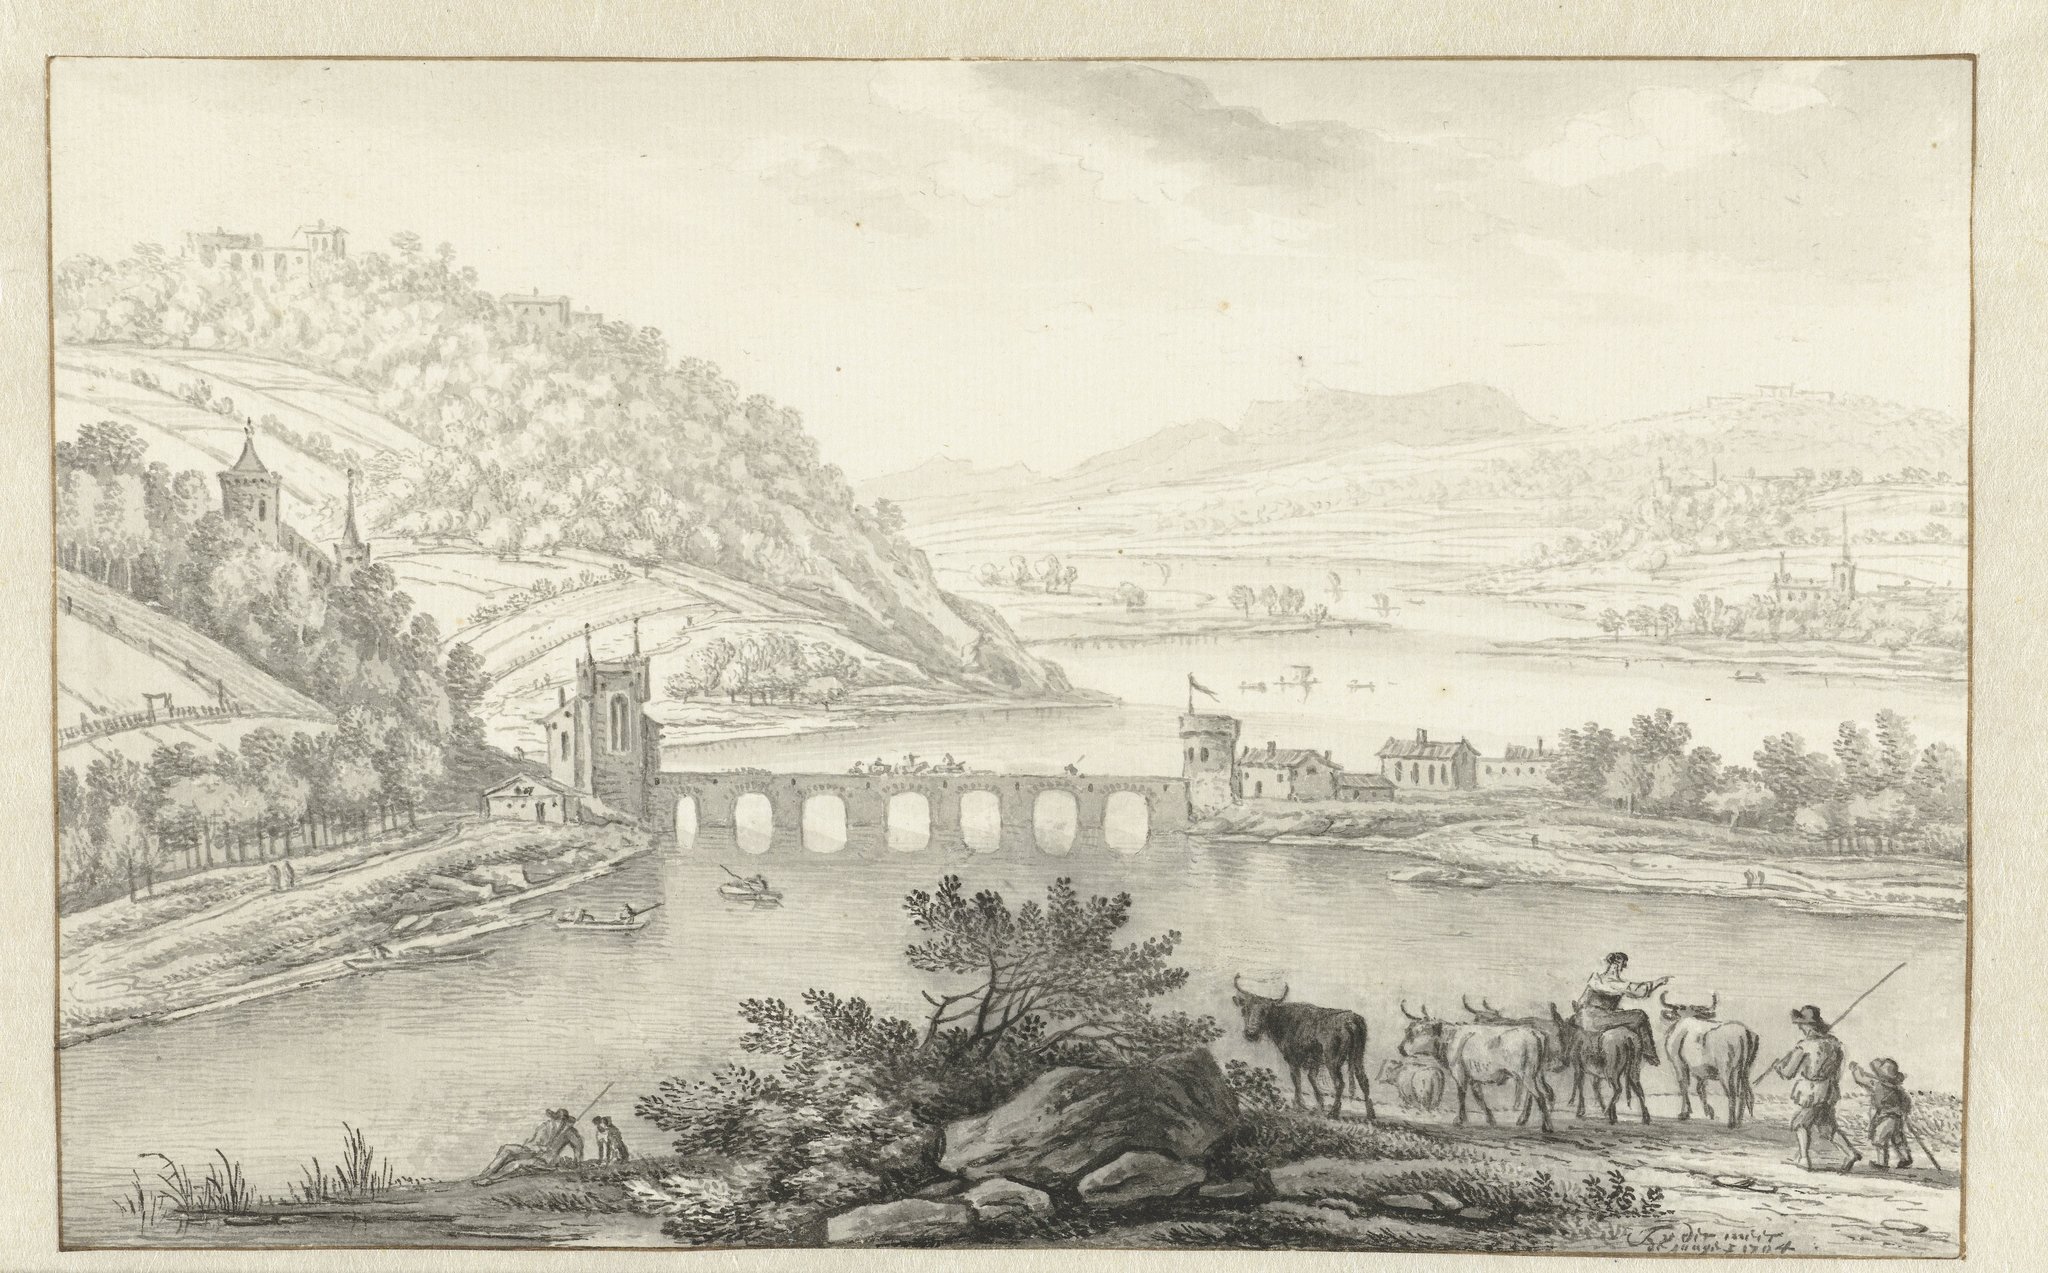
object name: drawing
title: Mountain Landscape with a Bridge across a River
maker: jan van der meer (ii)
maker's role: draughtsman, print maker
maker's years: 1656-1705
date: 1704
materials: graphite, ink, paper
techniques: brush, pen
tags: landscape with bridge, viaduct or aqueduct, landscapes with waters, waterscapes, seascapes (in the temperate zone), cattle driving, cattle driver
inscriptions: date: ‘1704’